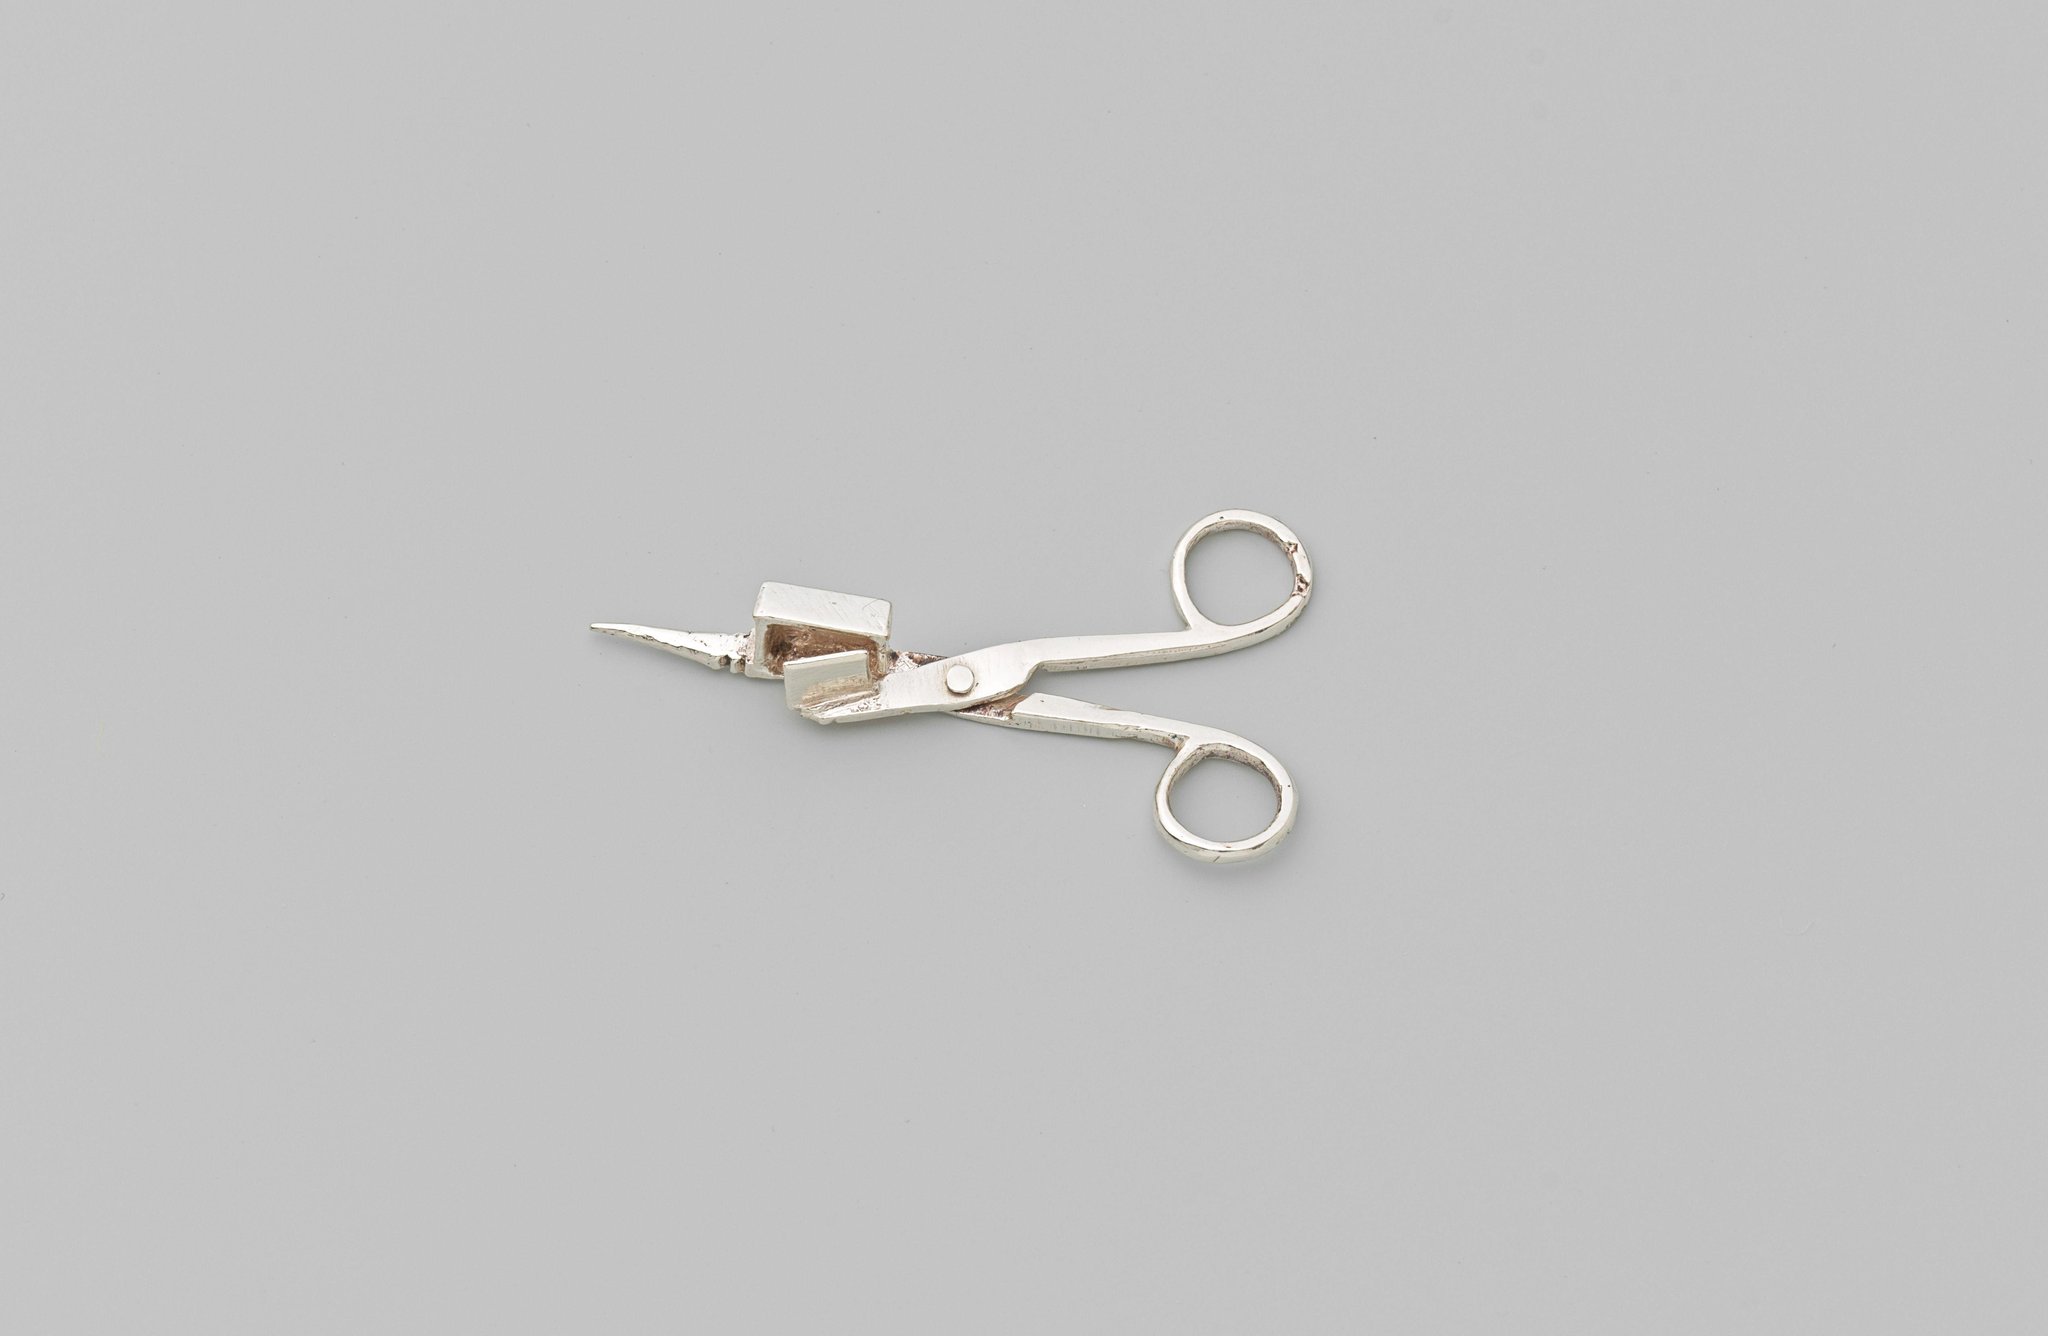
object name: kaarsensnuiter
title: Kaarsensnuiter van zilver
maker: Anonymous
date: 1650-1699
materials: silver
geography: amsterdam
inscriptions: maker's mark: ‘onduidelijk meesterteken’